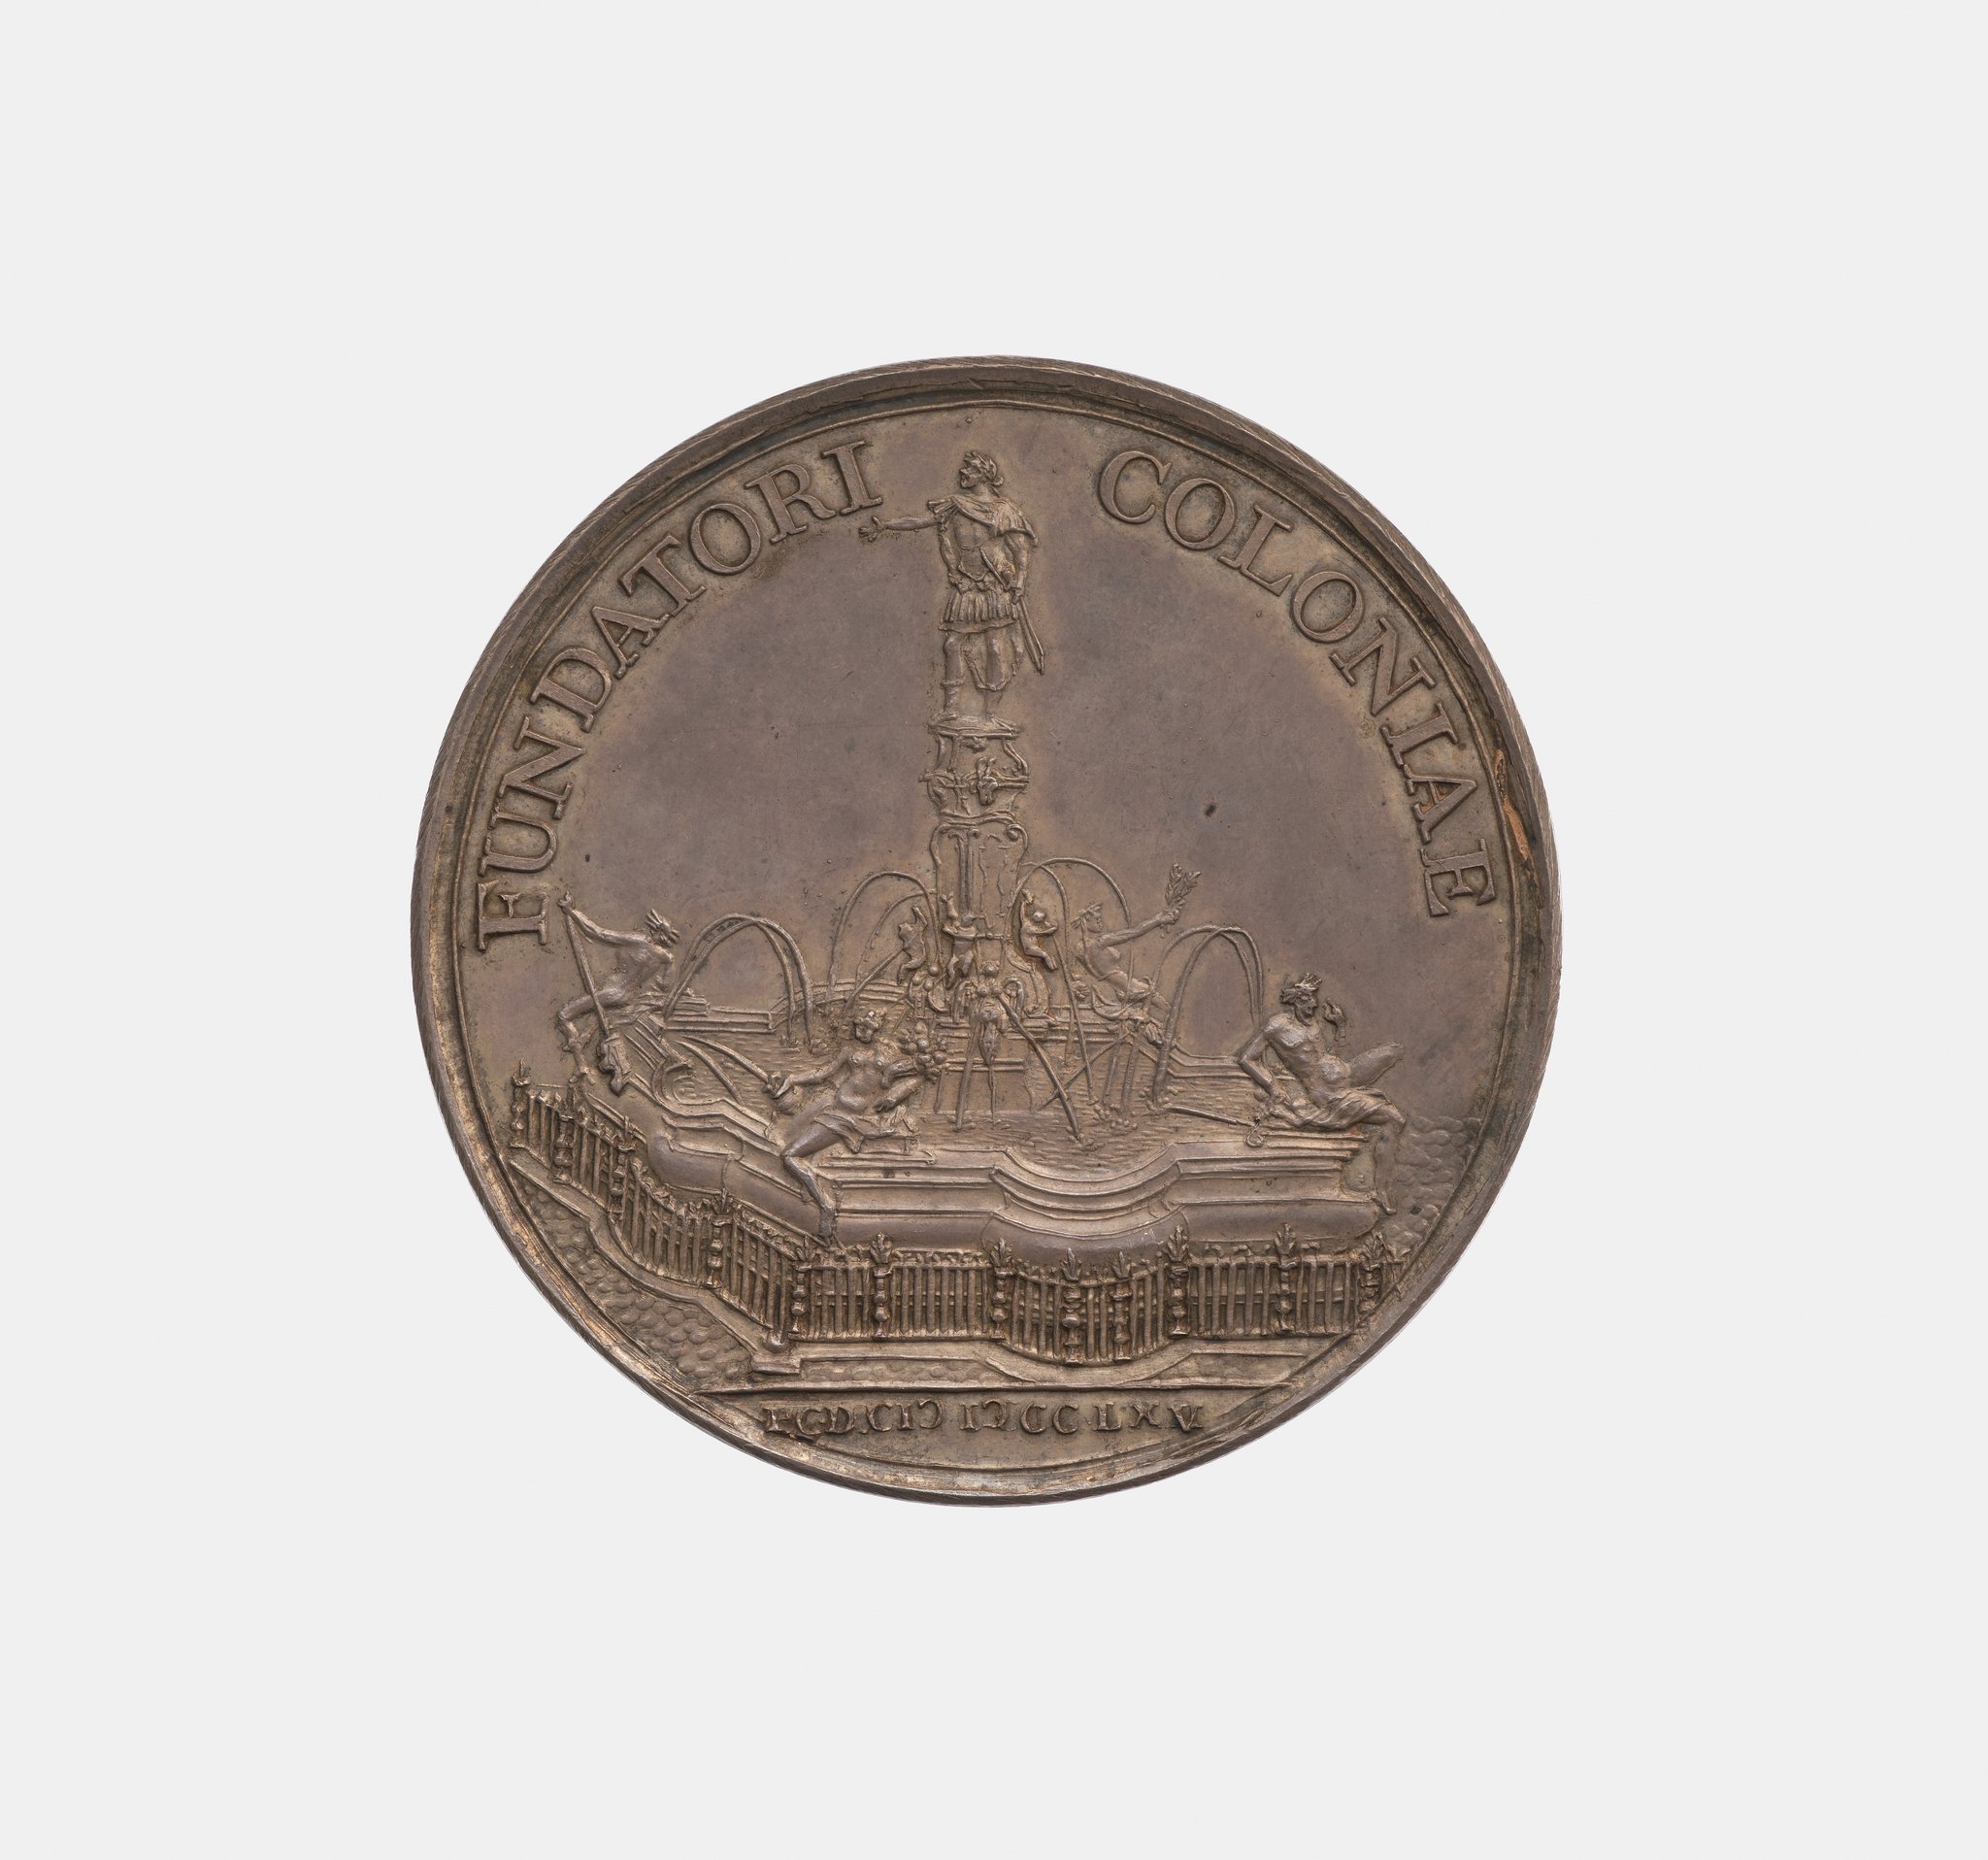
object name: medal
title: The Augustus Well (Augustusbrunnen) / Commemorative of founding of Augsburg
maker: jonas thiebaud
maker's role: artist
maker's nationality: swiss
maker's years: 1685-1769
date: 1765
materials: silver